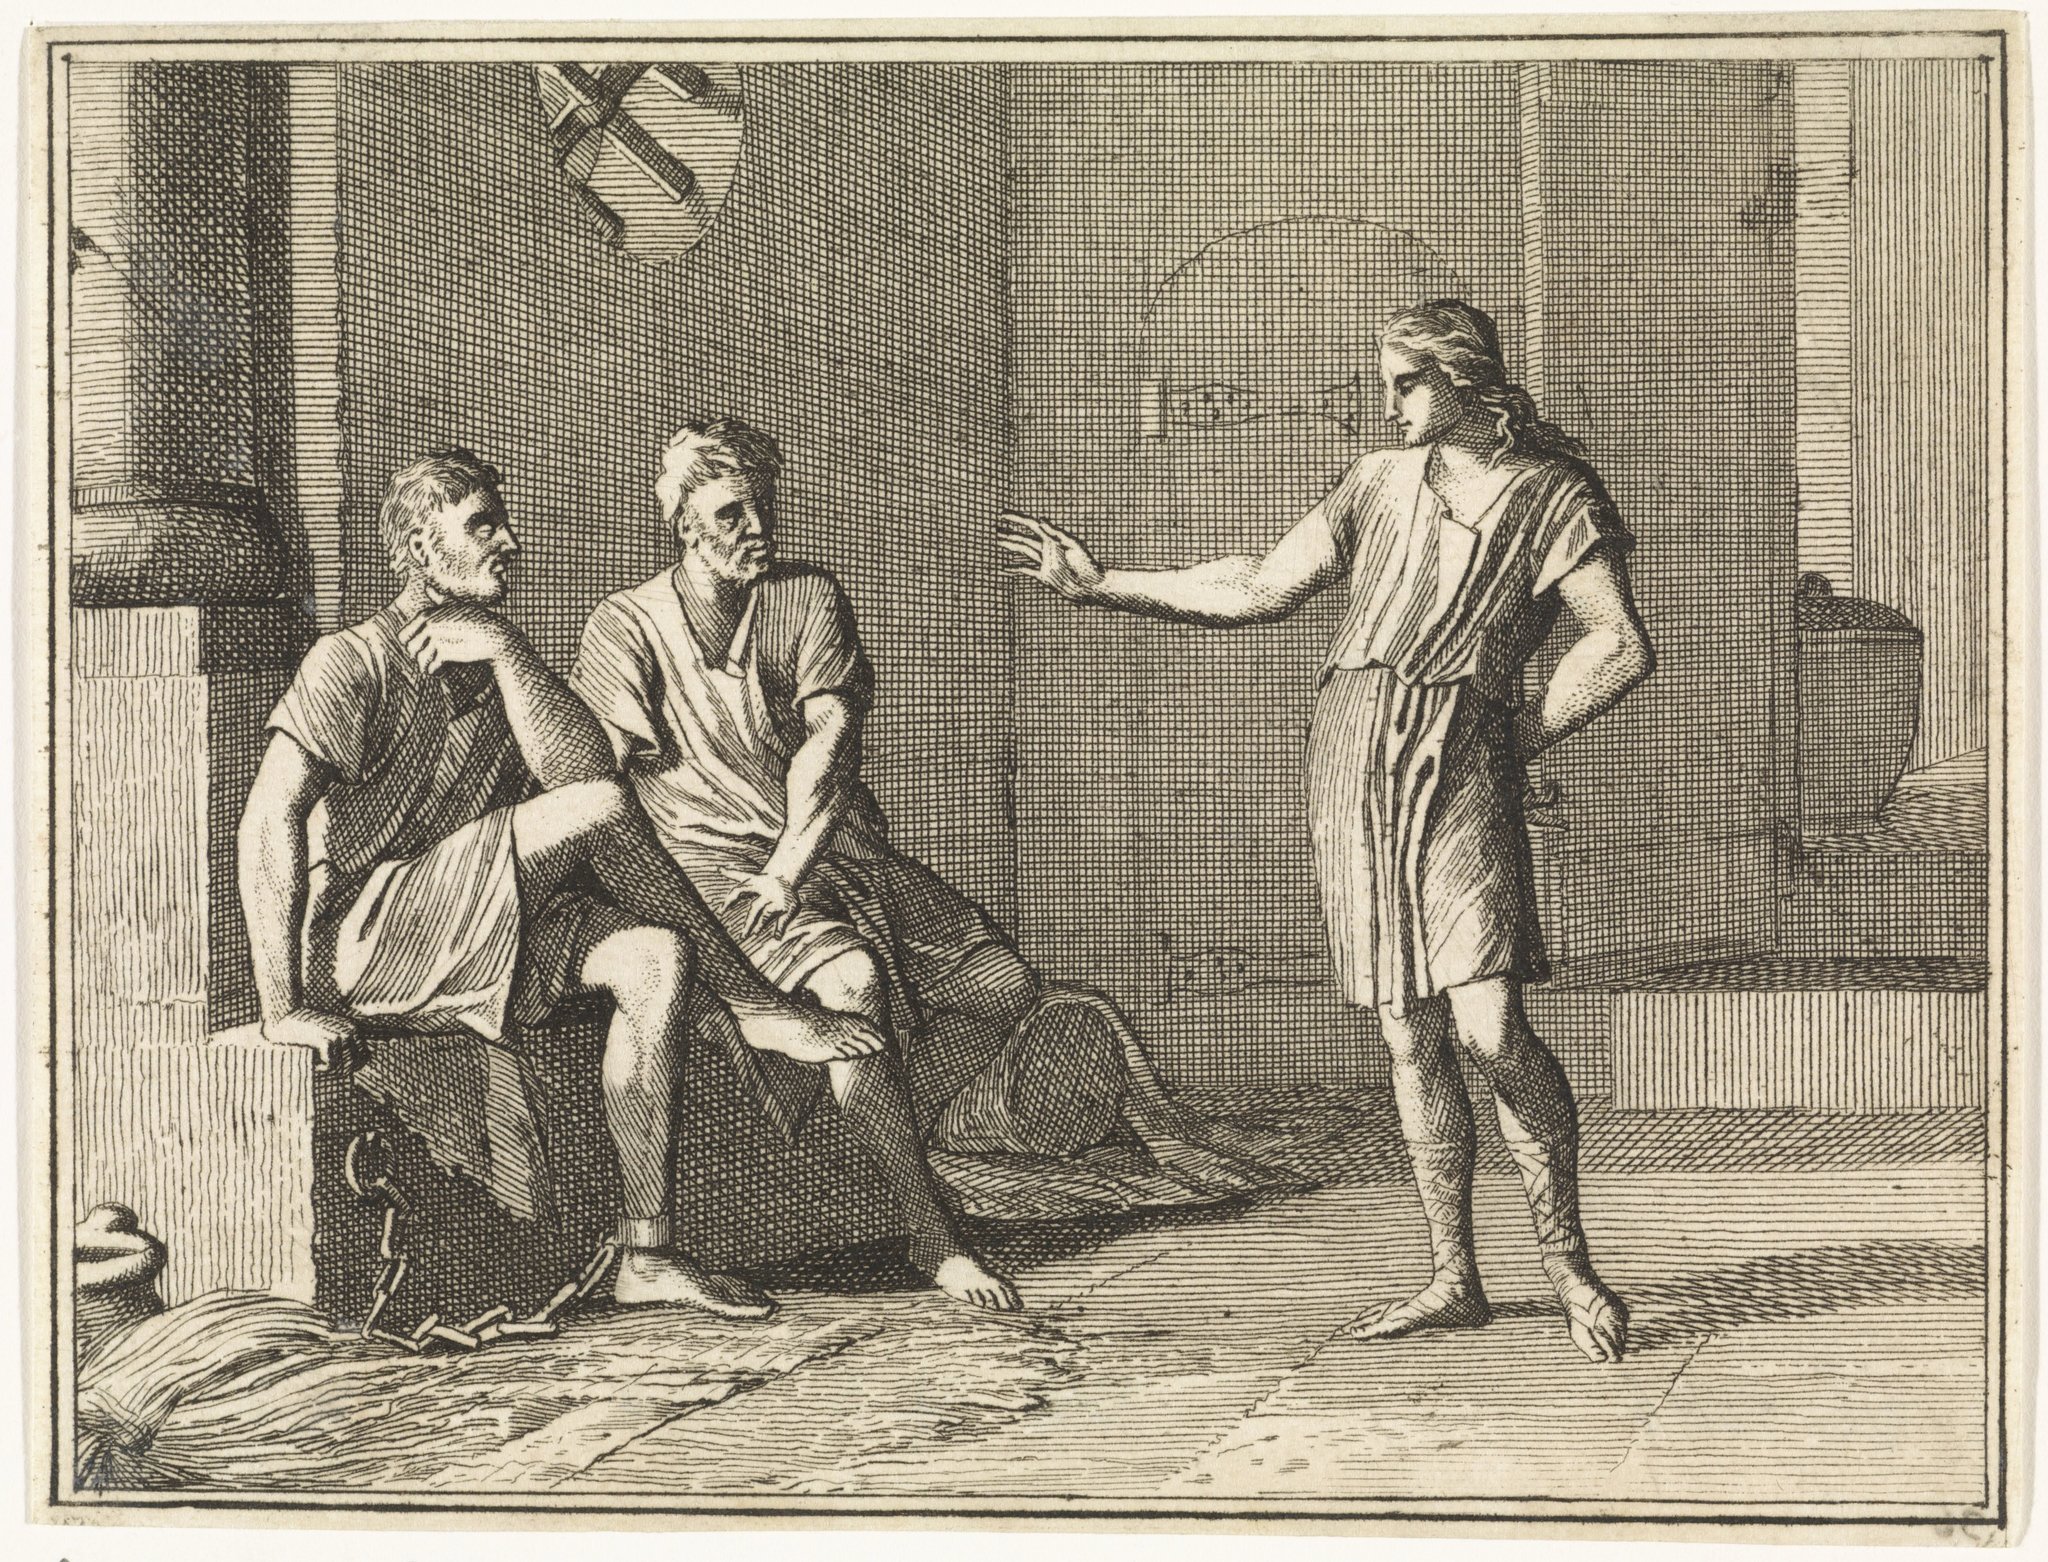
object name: print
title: Jozef verklaart de dromen van de bakker en de schenker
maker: caspar luyken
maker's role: draughtsman, print maker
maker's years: 1672-1708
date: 1712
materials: paper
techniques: etching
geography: amsterdam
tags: joseph interpreting the dreams of the butler and the baker (the two dreams combined)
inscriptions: collector's mark: Lugt 2228, number: ‘36’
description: Illustratie uit: Luyken, Jan. De schriftuurlyke geschiedenissen en gelykenissen van het Oude en Nieuwe Verbond, 2 delen. Amsterdam: Wed. Pieter Arentsz II en Cornelis van der Sys, 1712, dl. I.